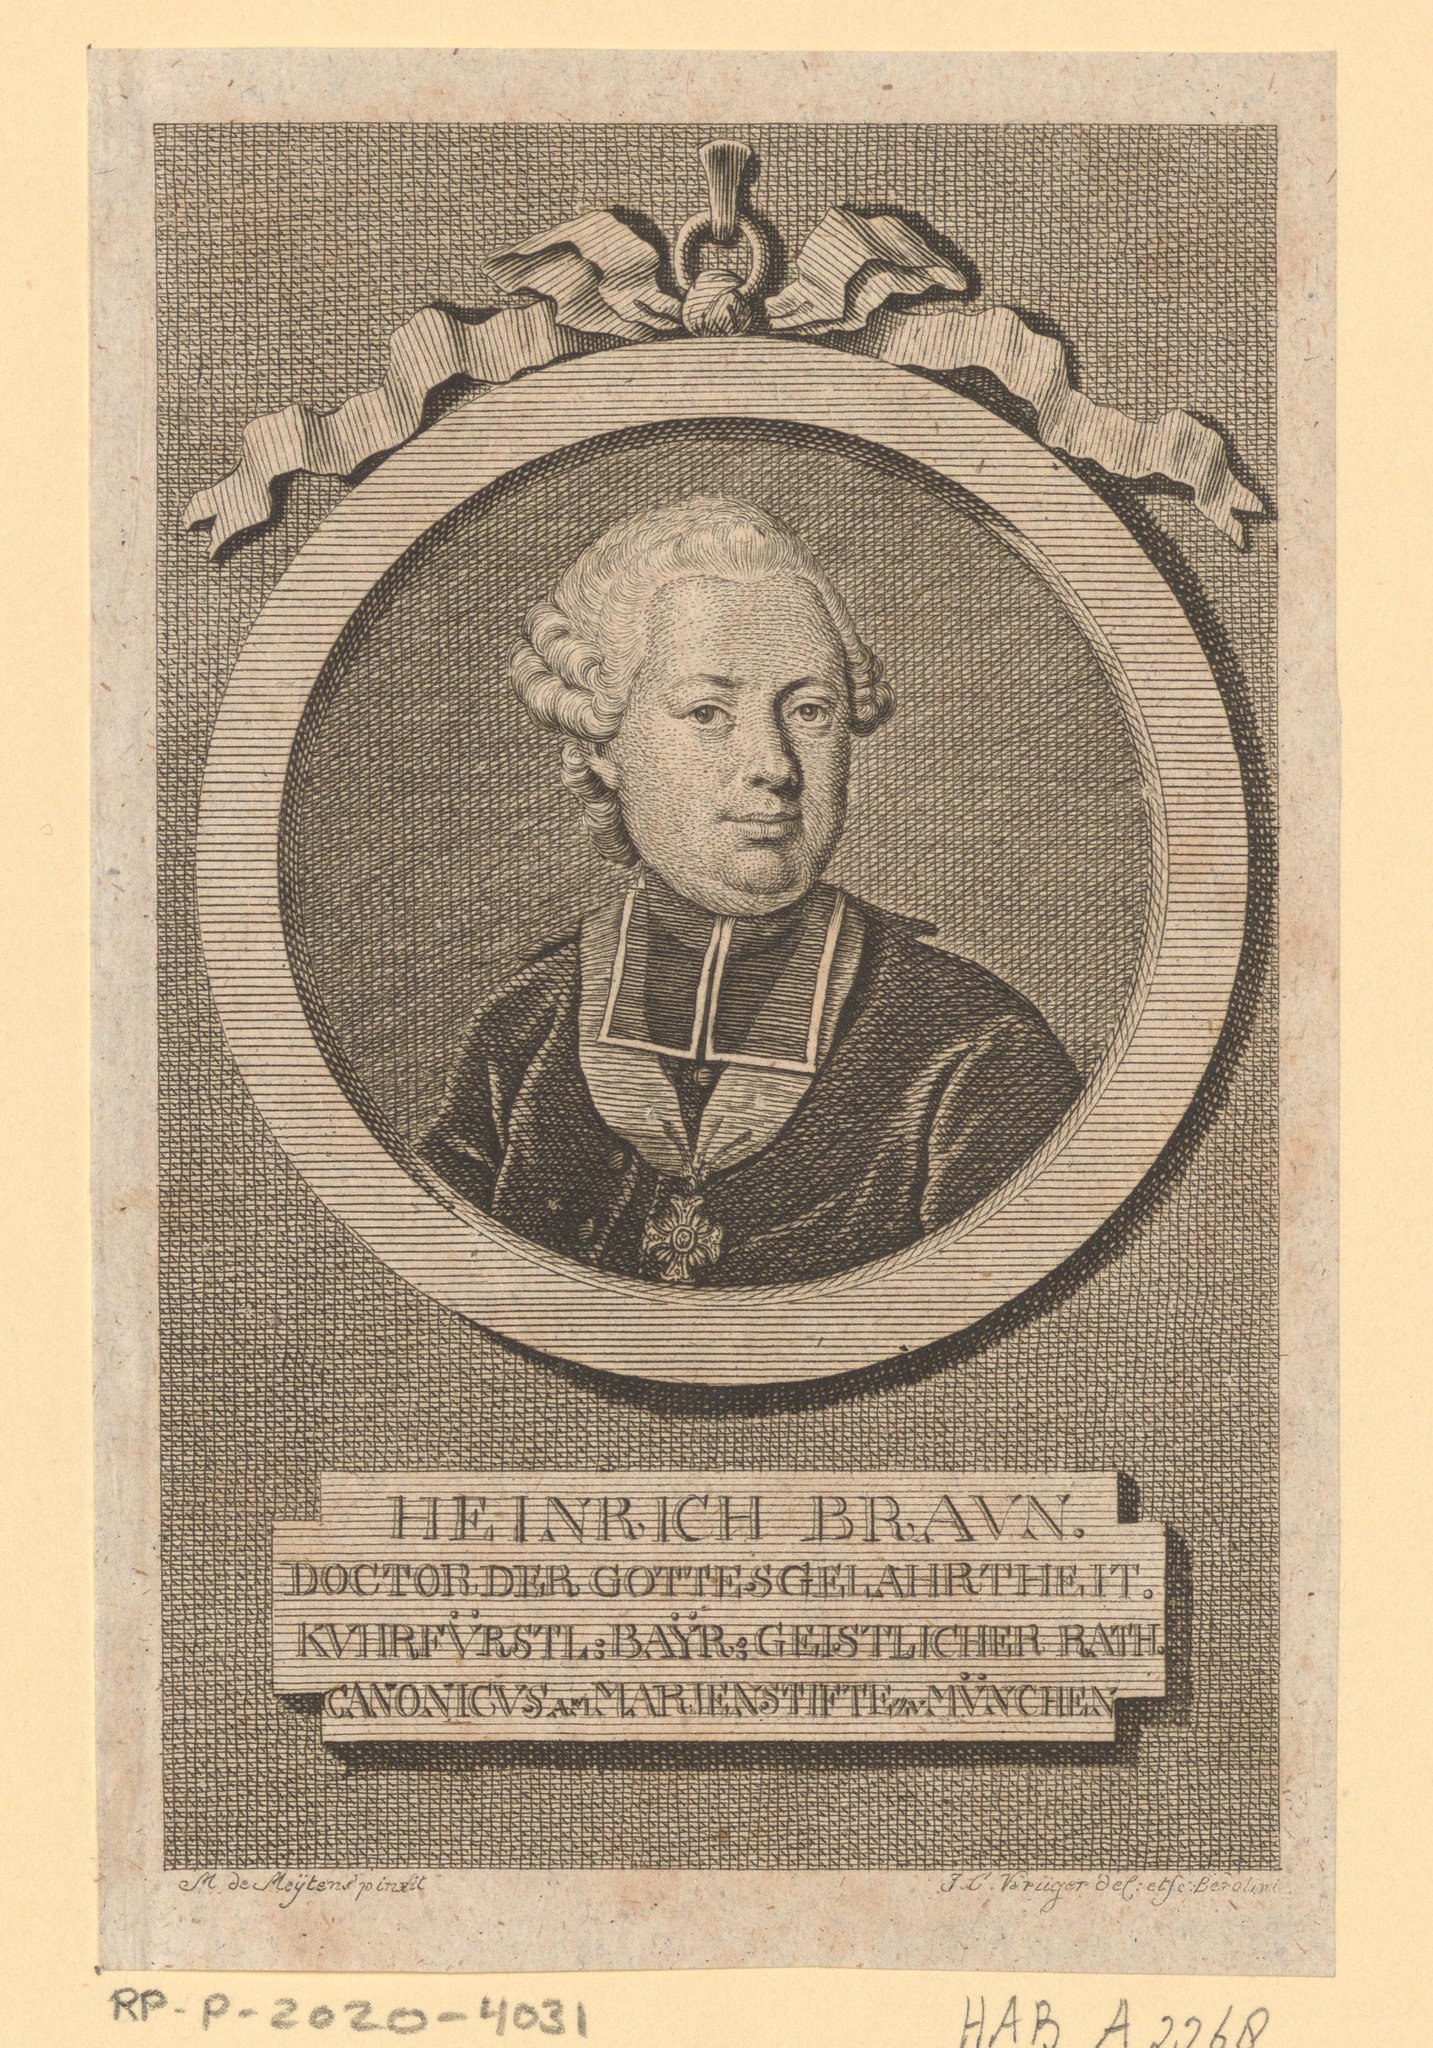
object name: print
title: Portret van Heinrich Braun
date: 1770-1791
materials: paper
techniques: engraving, etching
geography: berlin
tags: theologian, historical persons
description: Prent mogelijk uit: Allgemeine deutsche Bibliothek. Berlijn en Stettin: Friedrich Nicolai, 1777, dl. 31.